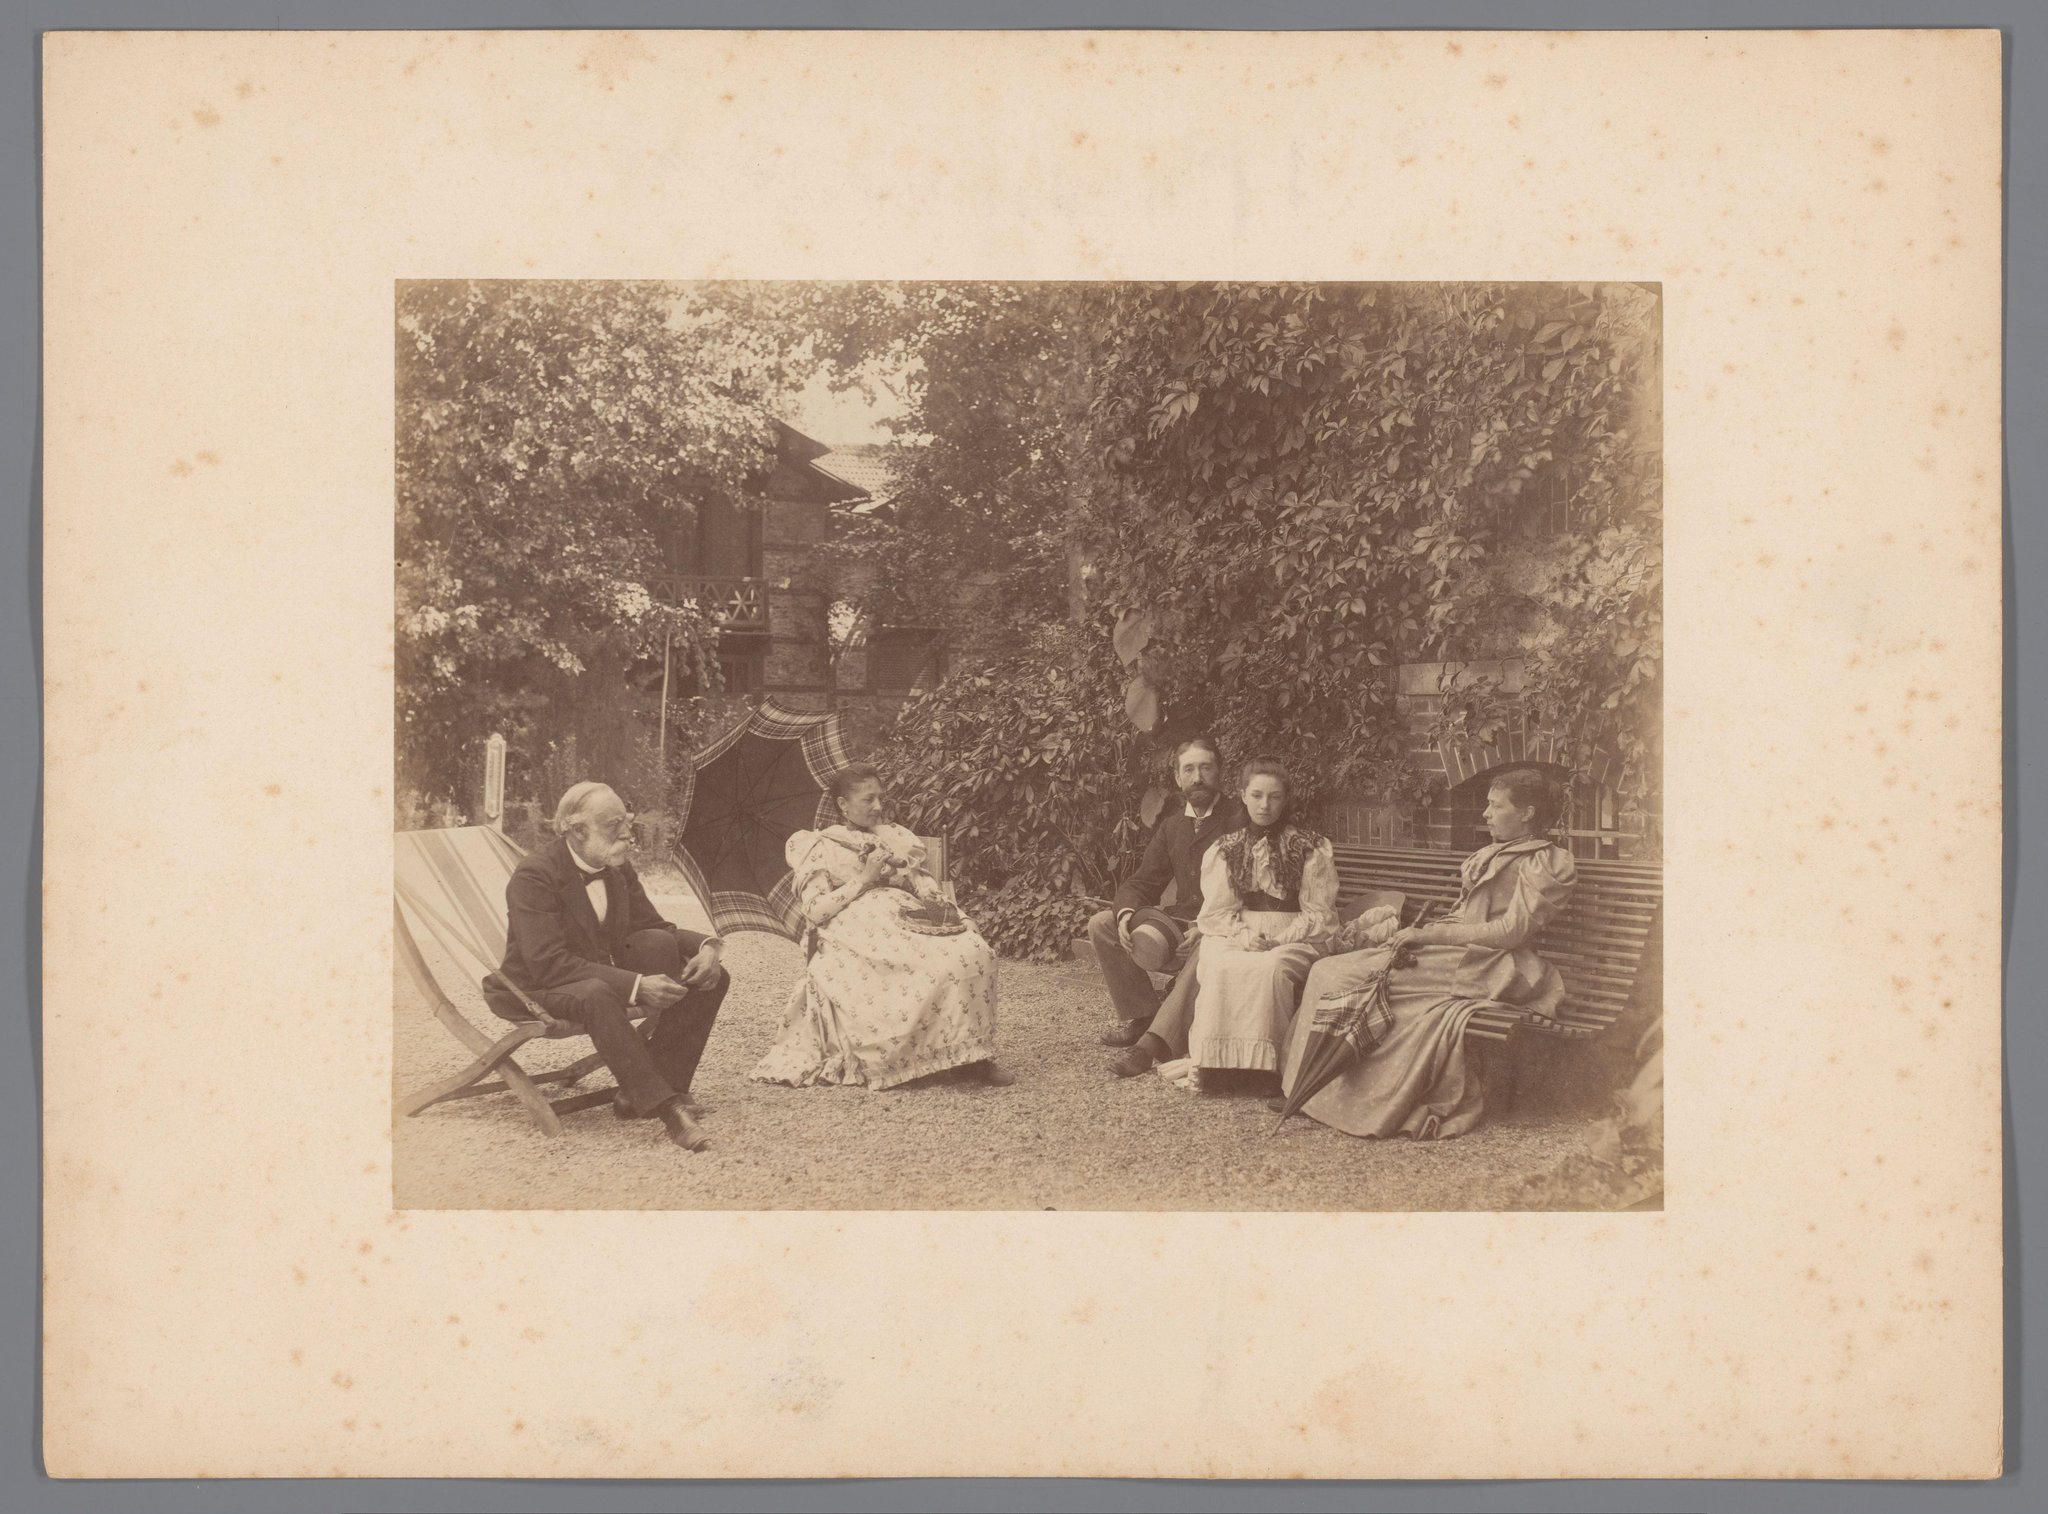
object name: photograph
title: Groepsportret van familie in tuin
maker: Anonymous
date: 1880-1910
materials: cardboard, paper, photographic support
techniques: albumen print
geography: france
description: Groepsportret van een familie (?) in een ommuurde tuin of park. Een vijftal personen poseert voor de camera: een oudere man links op ligstoel, vrouw met parasol en lichte jurk, een man en jonge vrouw op een bankje, daarnaast een wat oudere vrouw met ingeklapte parasol. Een huis en een thermometer (aan een hekje) op de achtergrond.